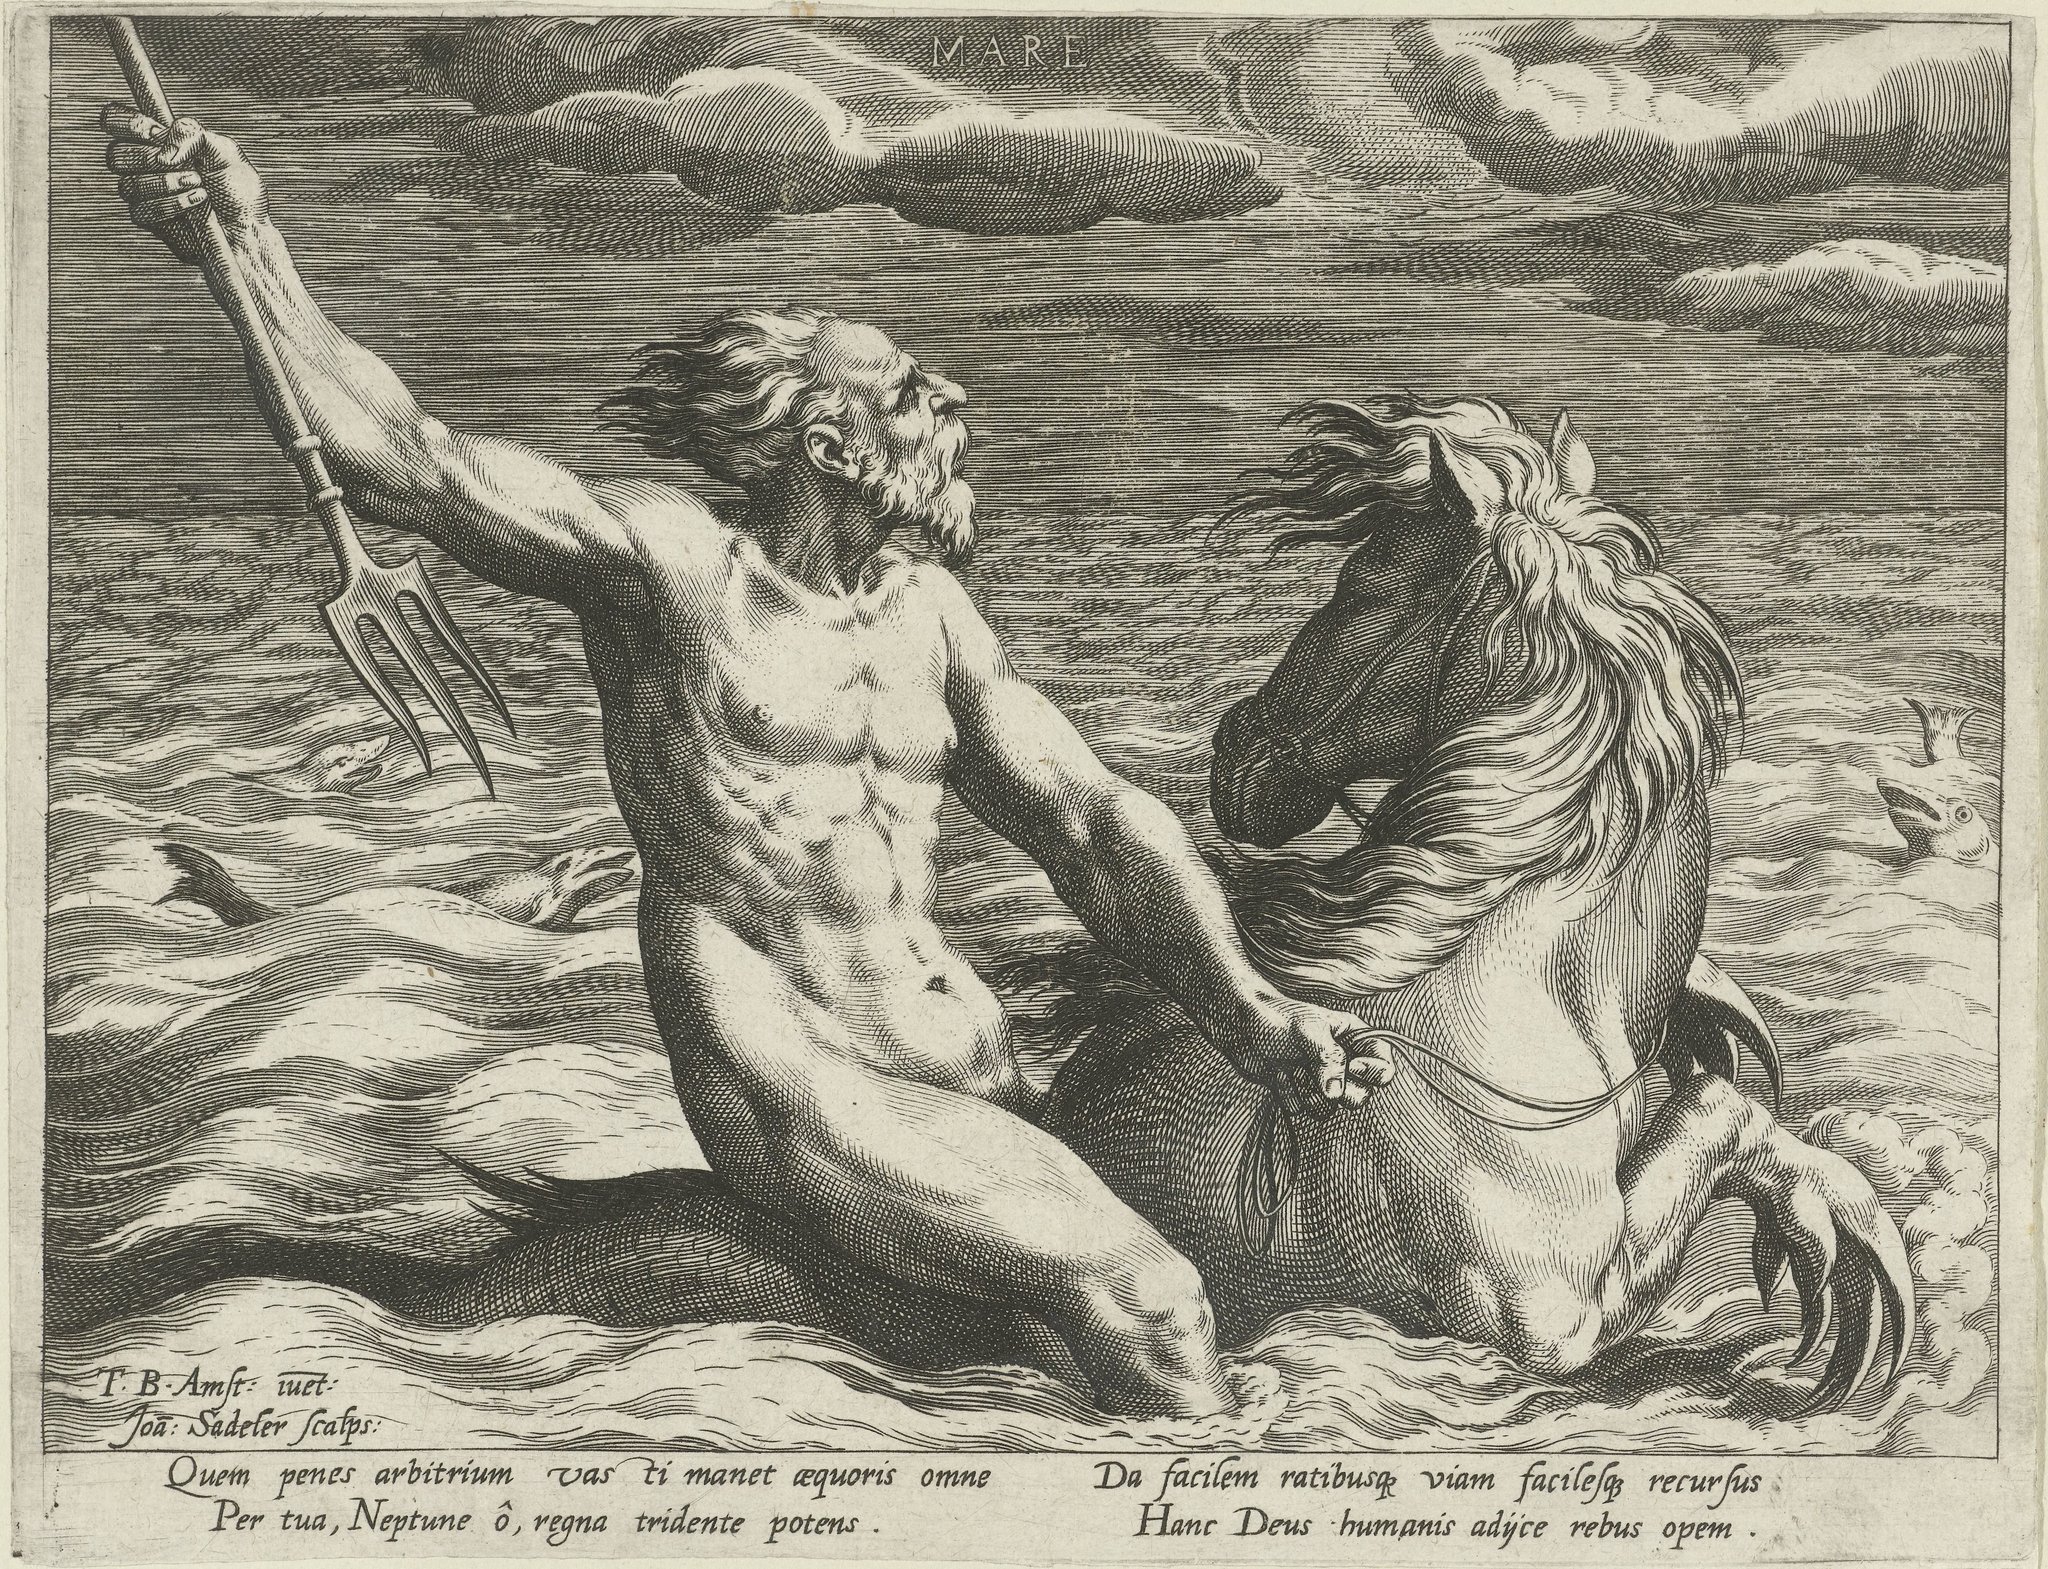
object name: print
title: Mare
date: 1587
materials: paper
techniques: engraving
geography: frankfurt am main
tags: (story of) neptune (poseidon), water (one of the four elements)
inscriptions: collector's mark: Lugt 240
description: Het element water, gepersonifieerd door Neptunus, rijdend op een zeepaard. In zijn ene hand een drietand. De prent heeft een Latijns onderschrift. en is deel van een vierdelige serie over de vier elementen.